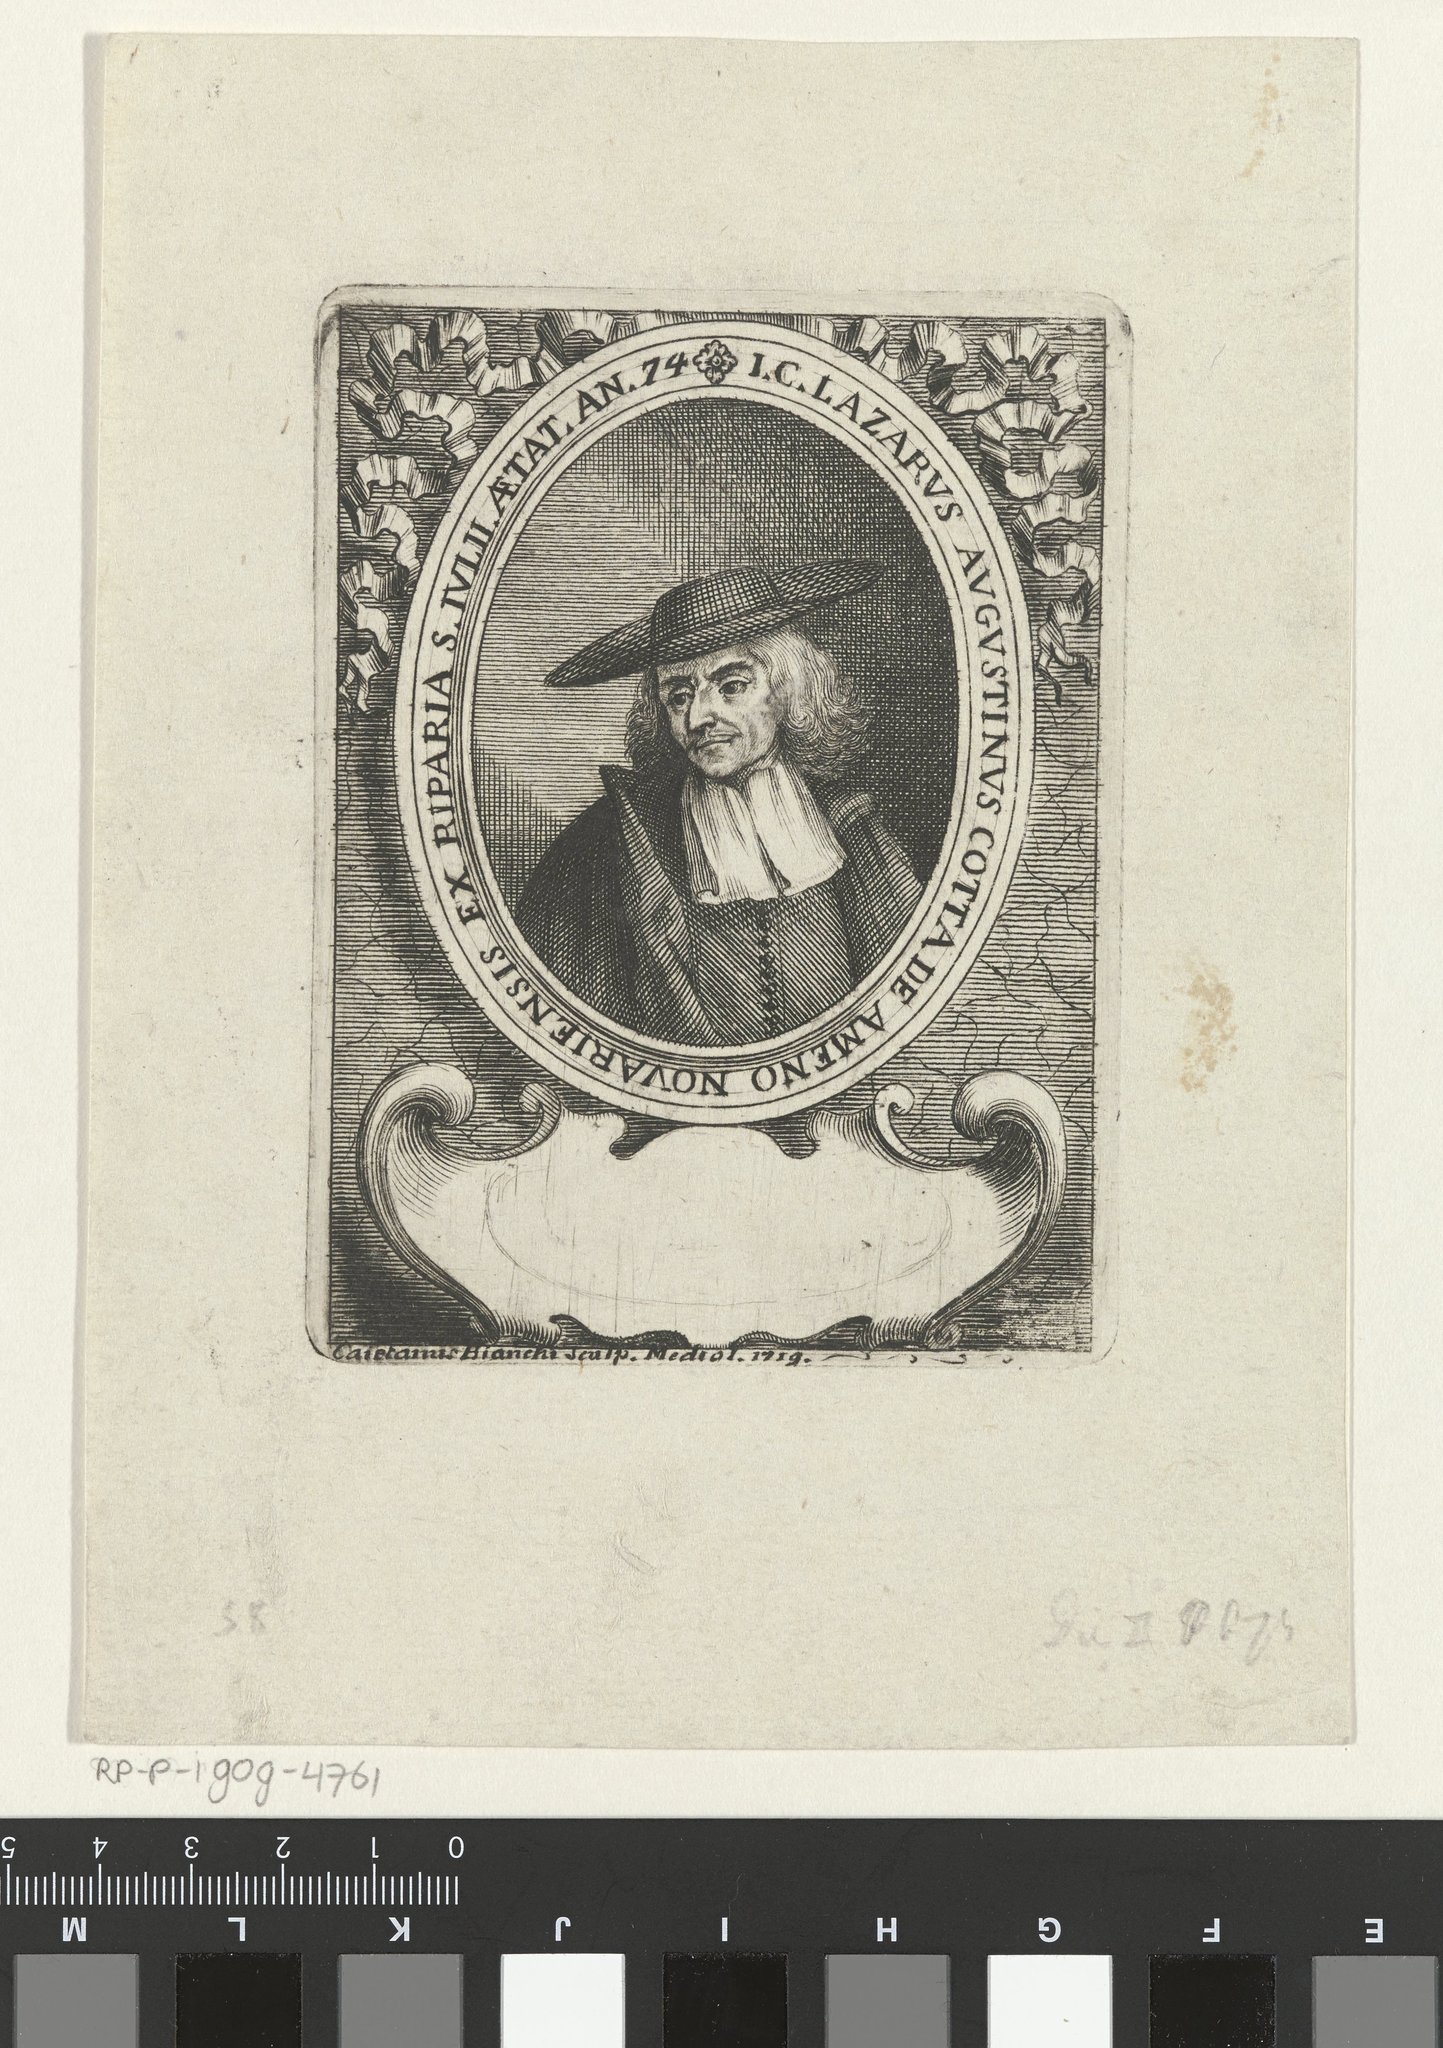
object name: print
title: Portret van Lazarus Augustinus Cotta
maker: gaetano bianchi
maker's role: print maker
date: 1719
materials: paper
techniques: engraving, etching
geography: italy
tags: historical persons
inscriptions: collector's mark: Lugt 2228